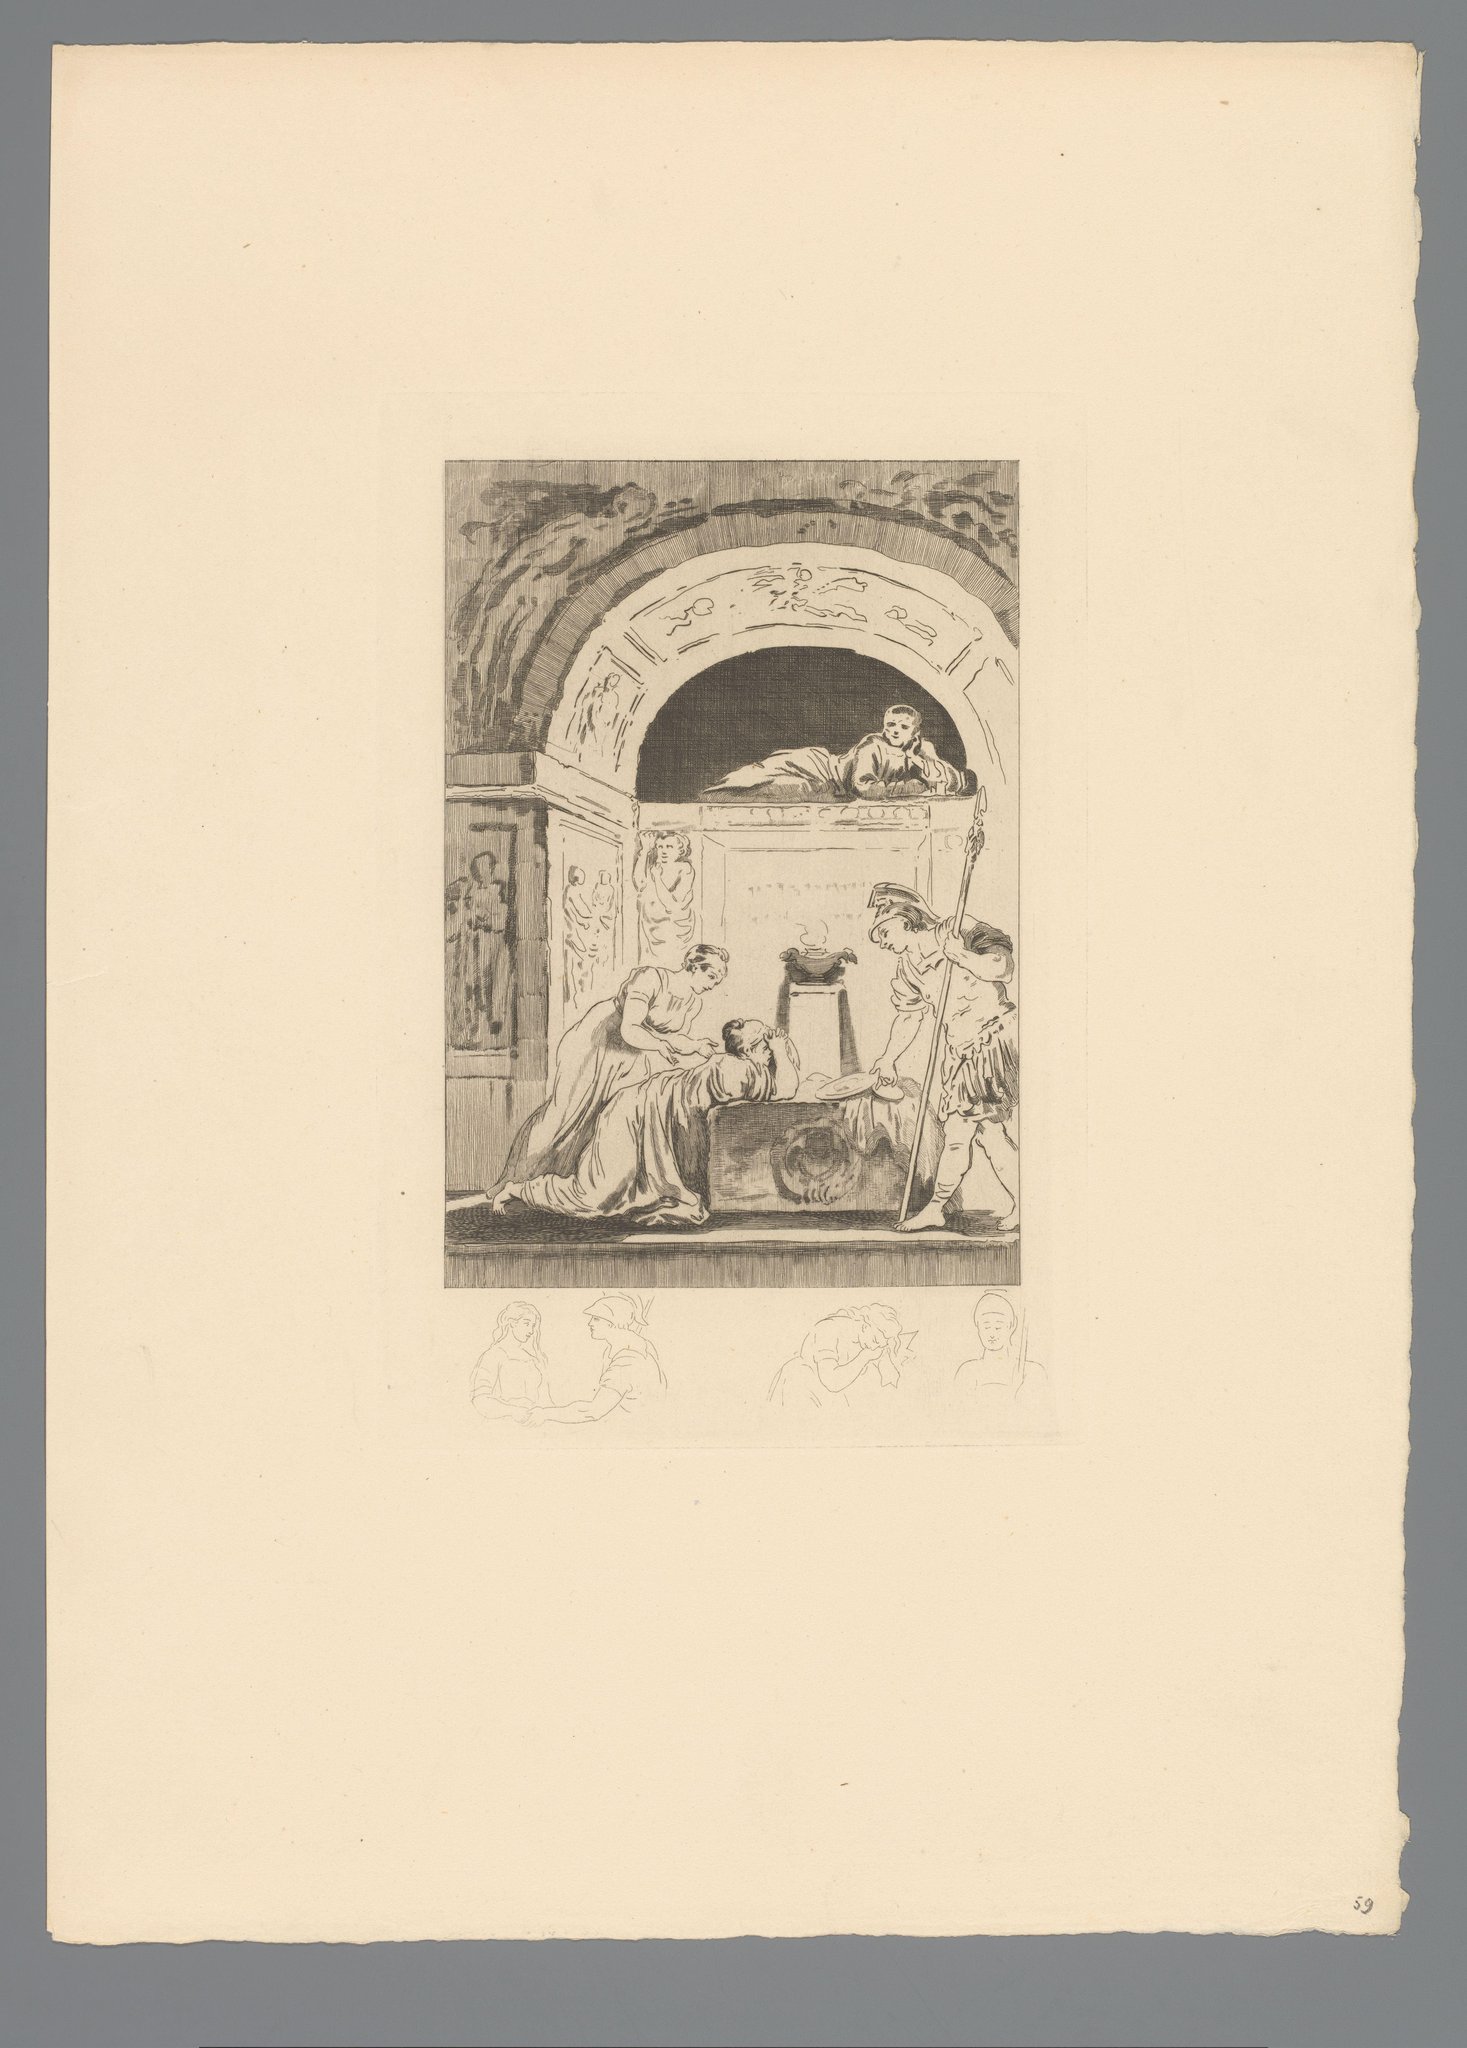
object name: reproduction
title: Figures des Contes de La Fontaine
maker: Anonymous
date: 1880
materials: paper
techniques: photoaquatint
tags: mourning the dead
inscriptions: collector's mark:, collector's mark: Lugt 2228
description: Martial Potémont maakte etsen naar de tekeningen van Fragonard, die zich bevonden in een manuscript in de collectie van de verzamelaar Eugène Paillet. Rouquette bood hem aan de tekeningen zo exact mogelijk in prent te laten brengen door Martial Potémont: dit resulteerde in een serie van 57 etsen. Vervolgens werden deze gereproduceerd door middel van heliogravure. Deze omslag betreft een editie voor de letter, "Eau forte pure", de 1e staat van 3 waar men uit kon kiezen bij deze serie.